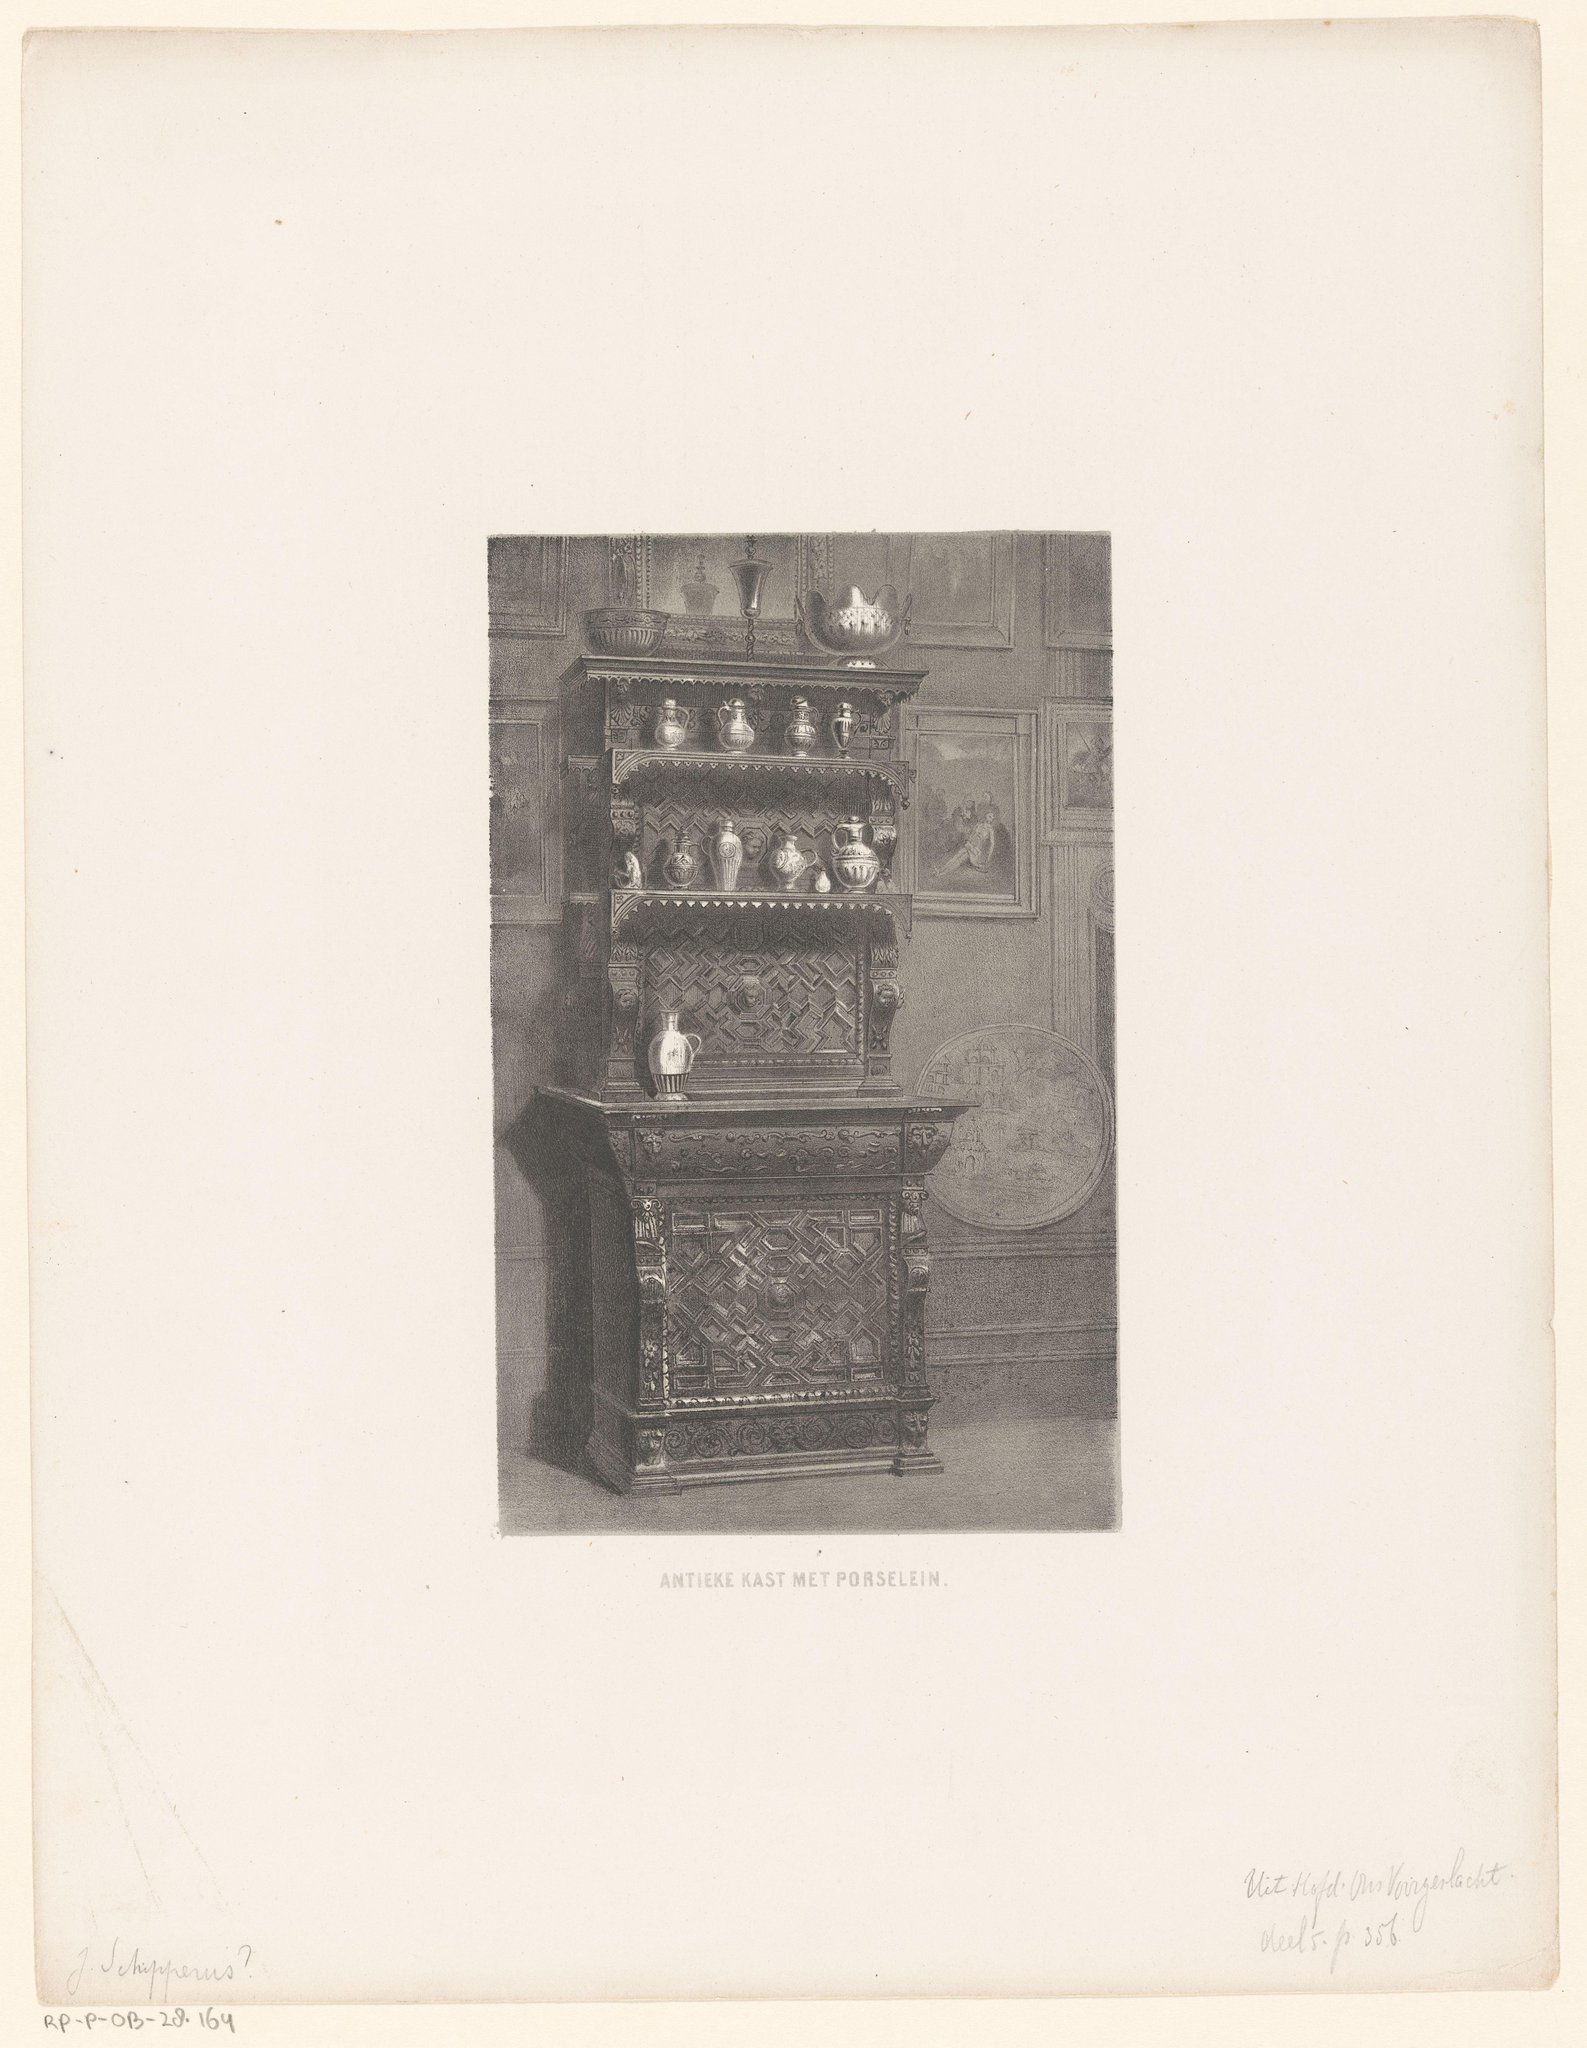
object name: print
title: Antieke kast met porselein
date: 1857-1864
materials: paper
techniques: tone lithography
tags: ornamental cupboard, container of ceramics: jar, jug, pot, vase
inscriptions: collector's mark: Lugt 2228, inscription: ‘J. Schipperus?’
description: De kast staat tegen een muur met ingelijste schilderijen.